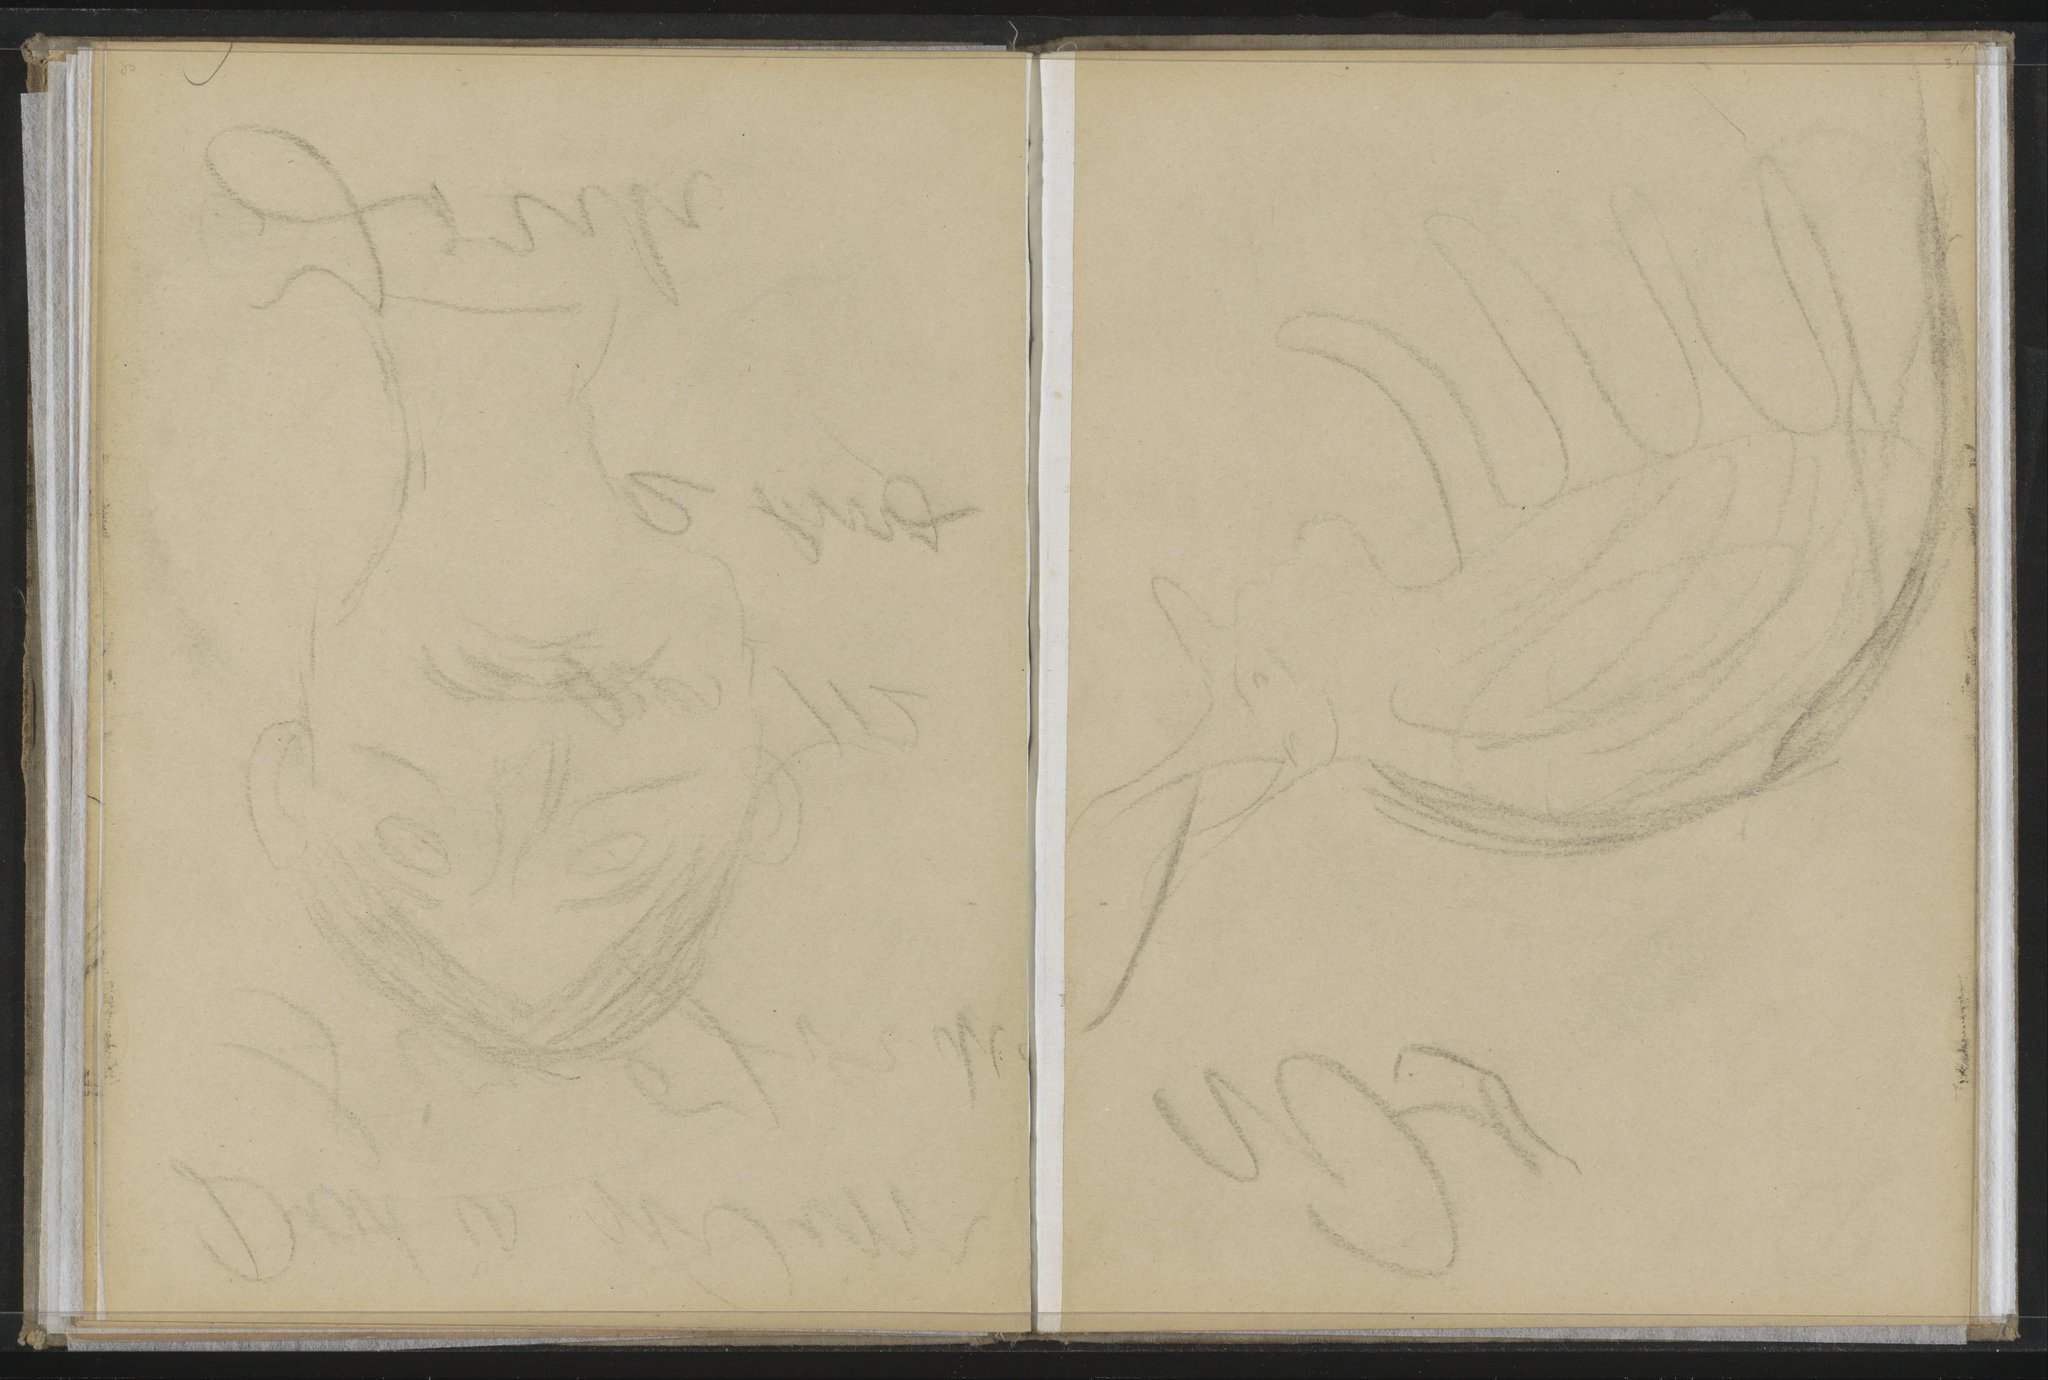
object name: sketchbook leaf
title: Mannenhoofd en een dierstudie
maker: willem witsen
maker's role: draughtsman, painter, print maker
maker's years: 1860-1923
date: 1893-1897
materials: chalk, paper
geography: ede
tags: head (human), animals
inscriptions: annotation: ‘[...]’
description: Pagina 30 en pagina 31 uit een schetsboek met 25 bladen.